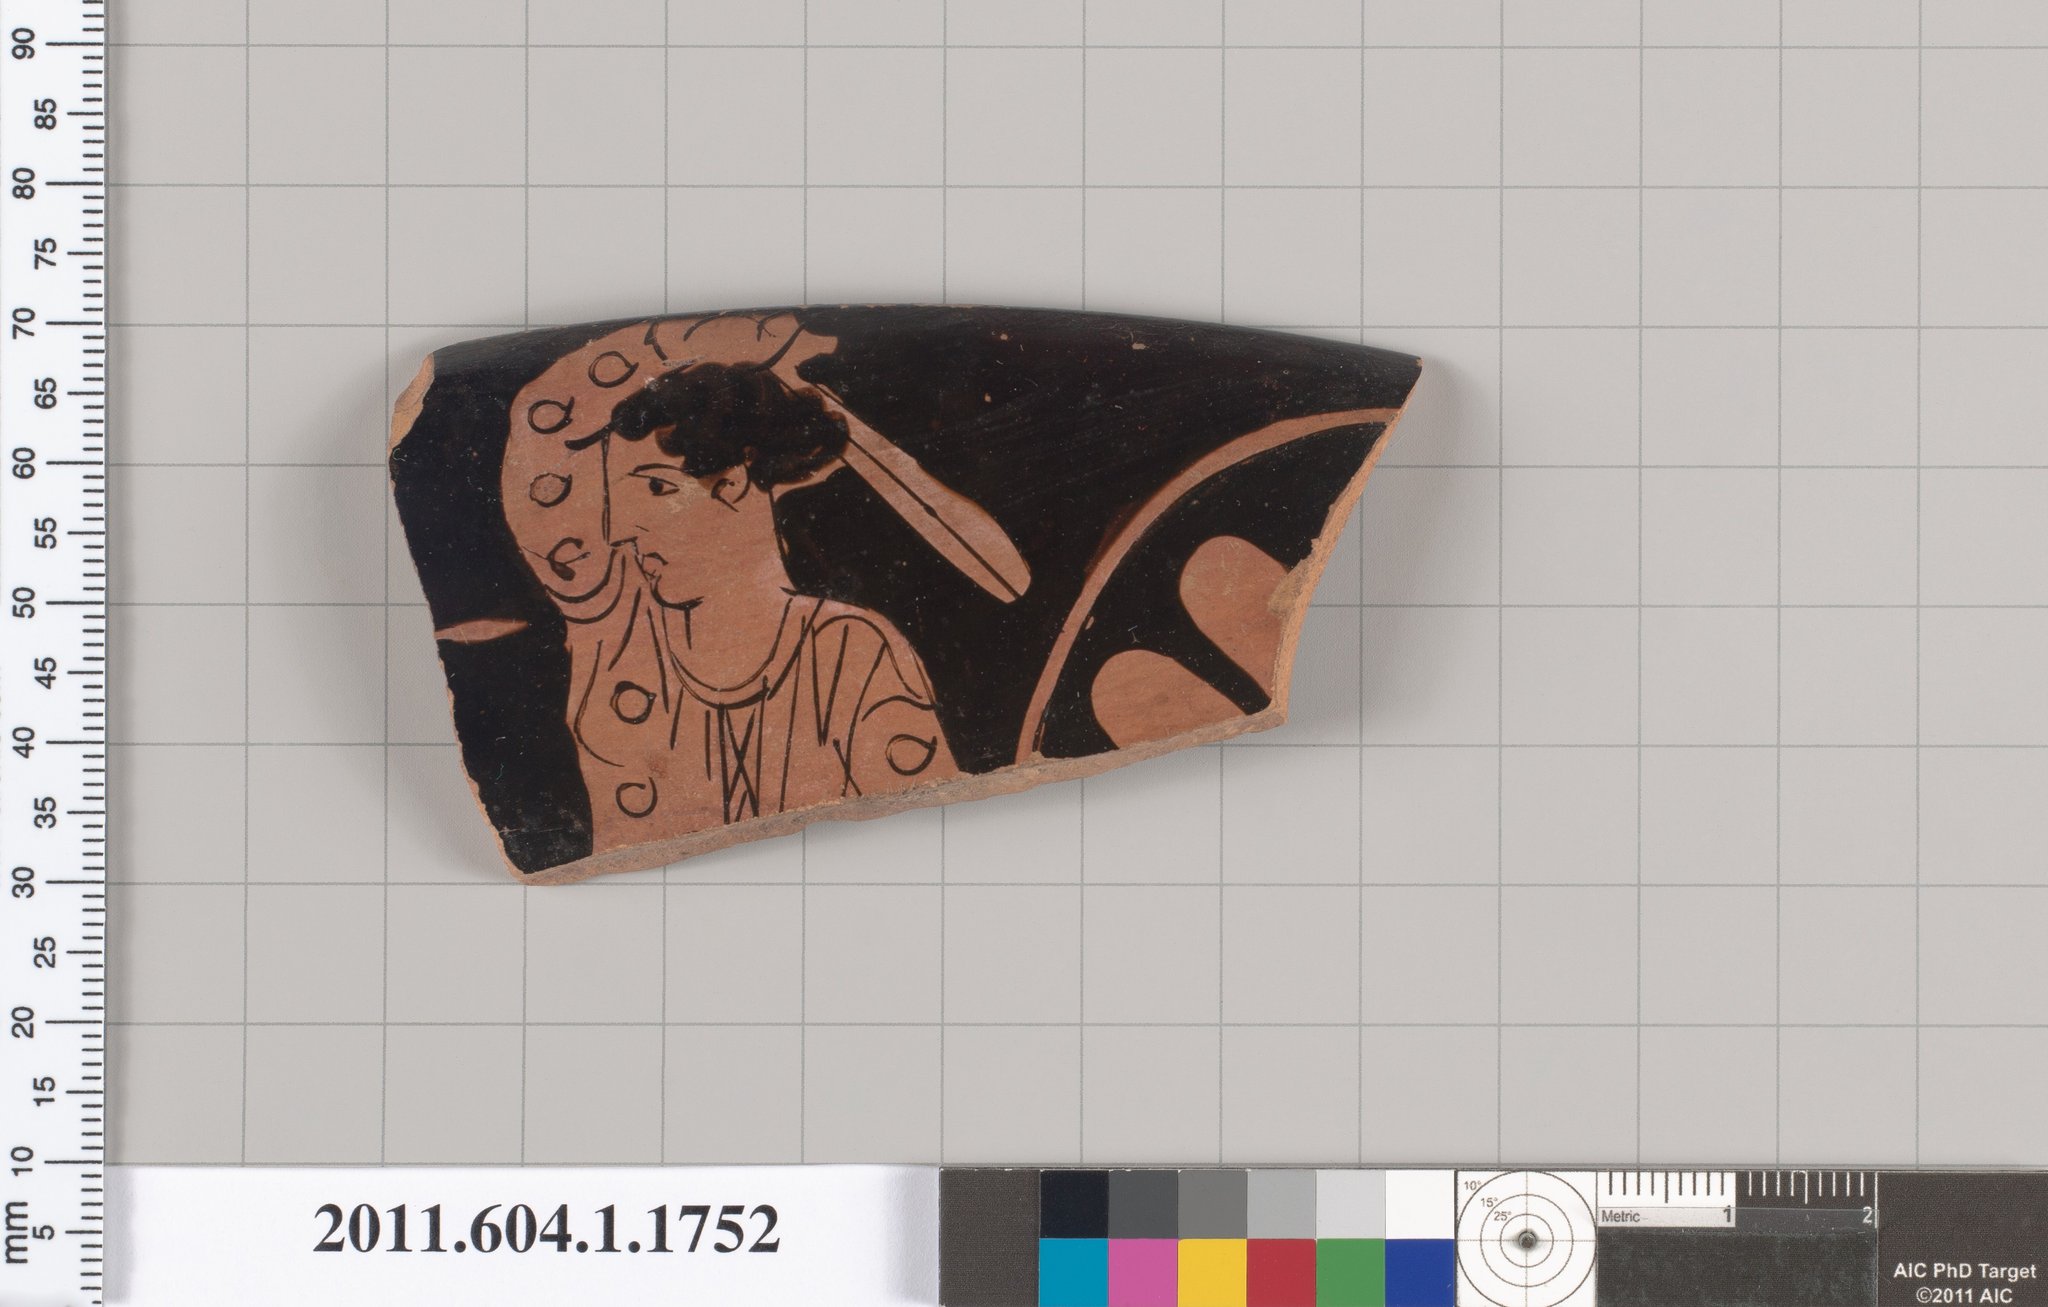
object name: kylix fragment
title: Terracotta rim fragment of a kylix (drinking cup)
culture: greek, attic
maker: marlay painter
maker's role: artist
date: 467-435 BCE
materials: terracotta